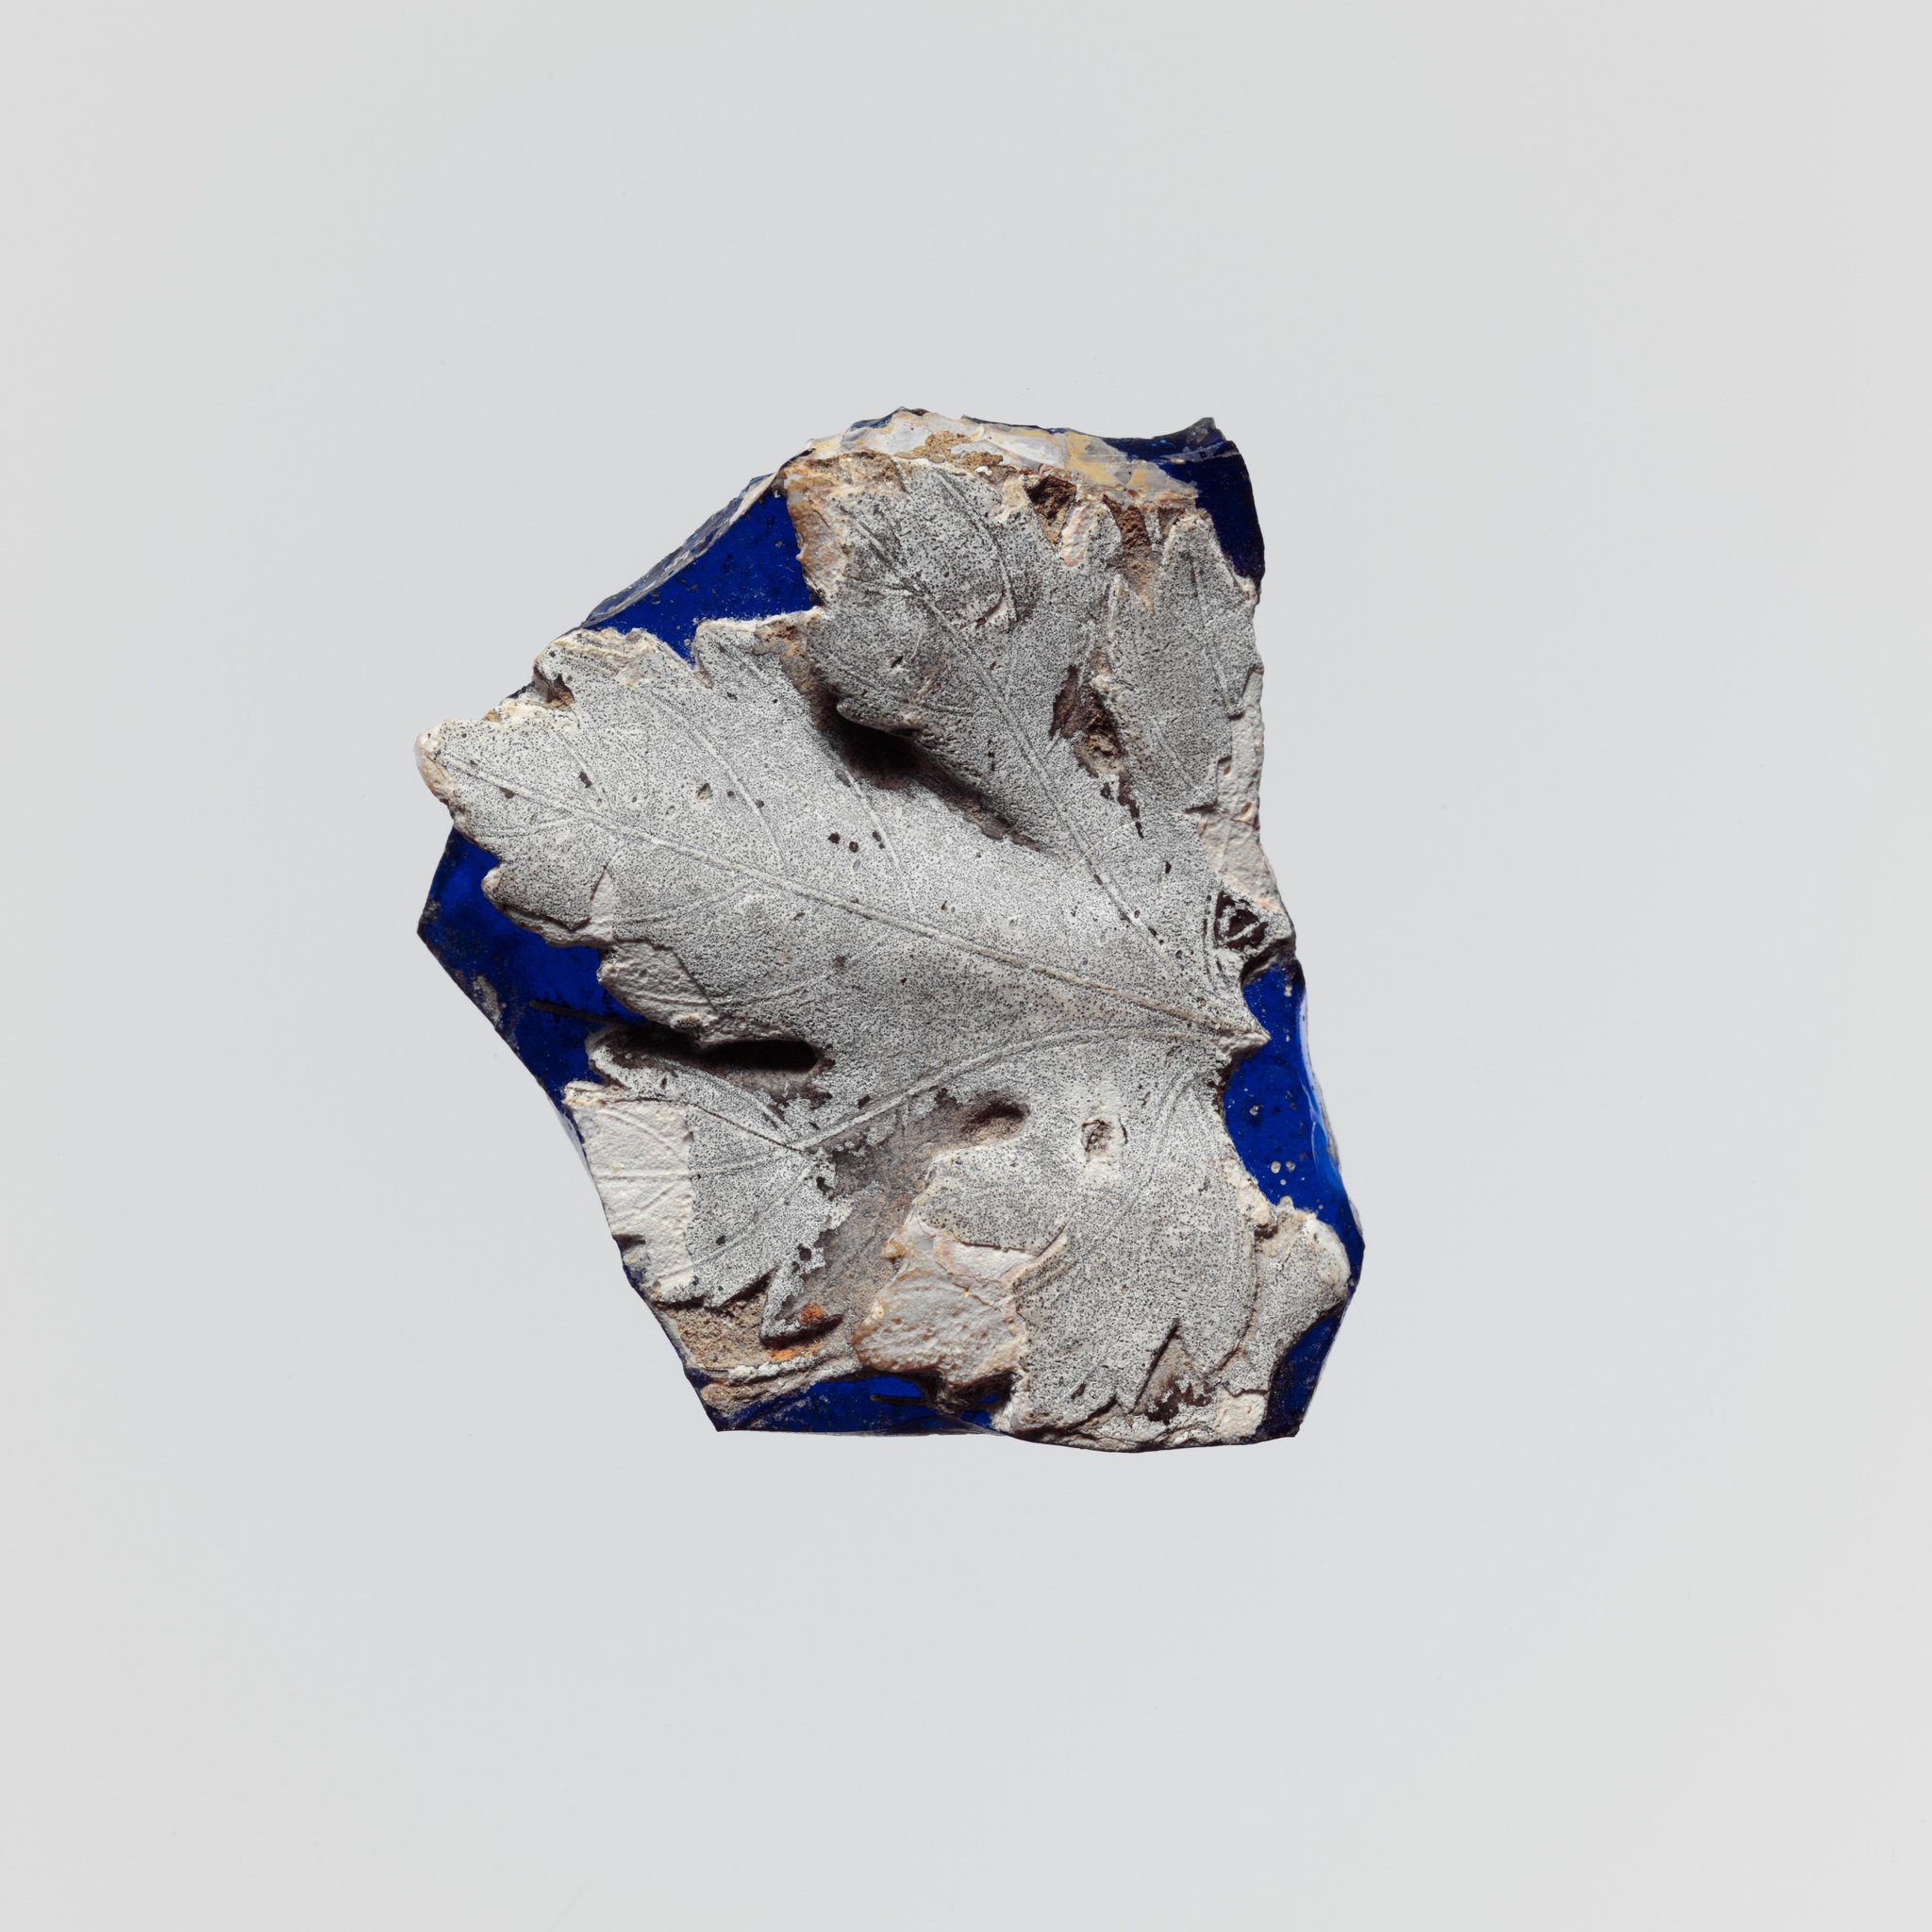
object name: cameo, fragment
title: Glass cameo fragment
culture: roman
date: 67-100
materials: glass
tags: leaves